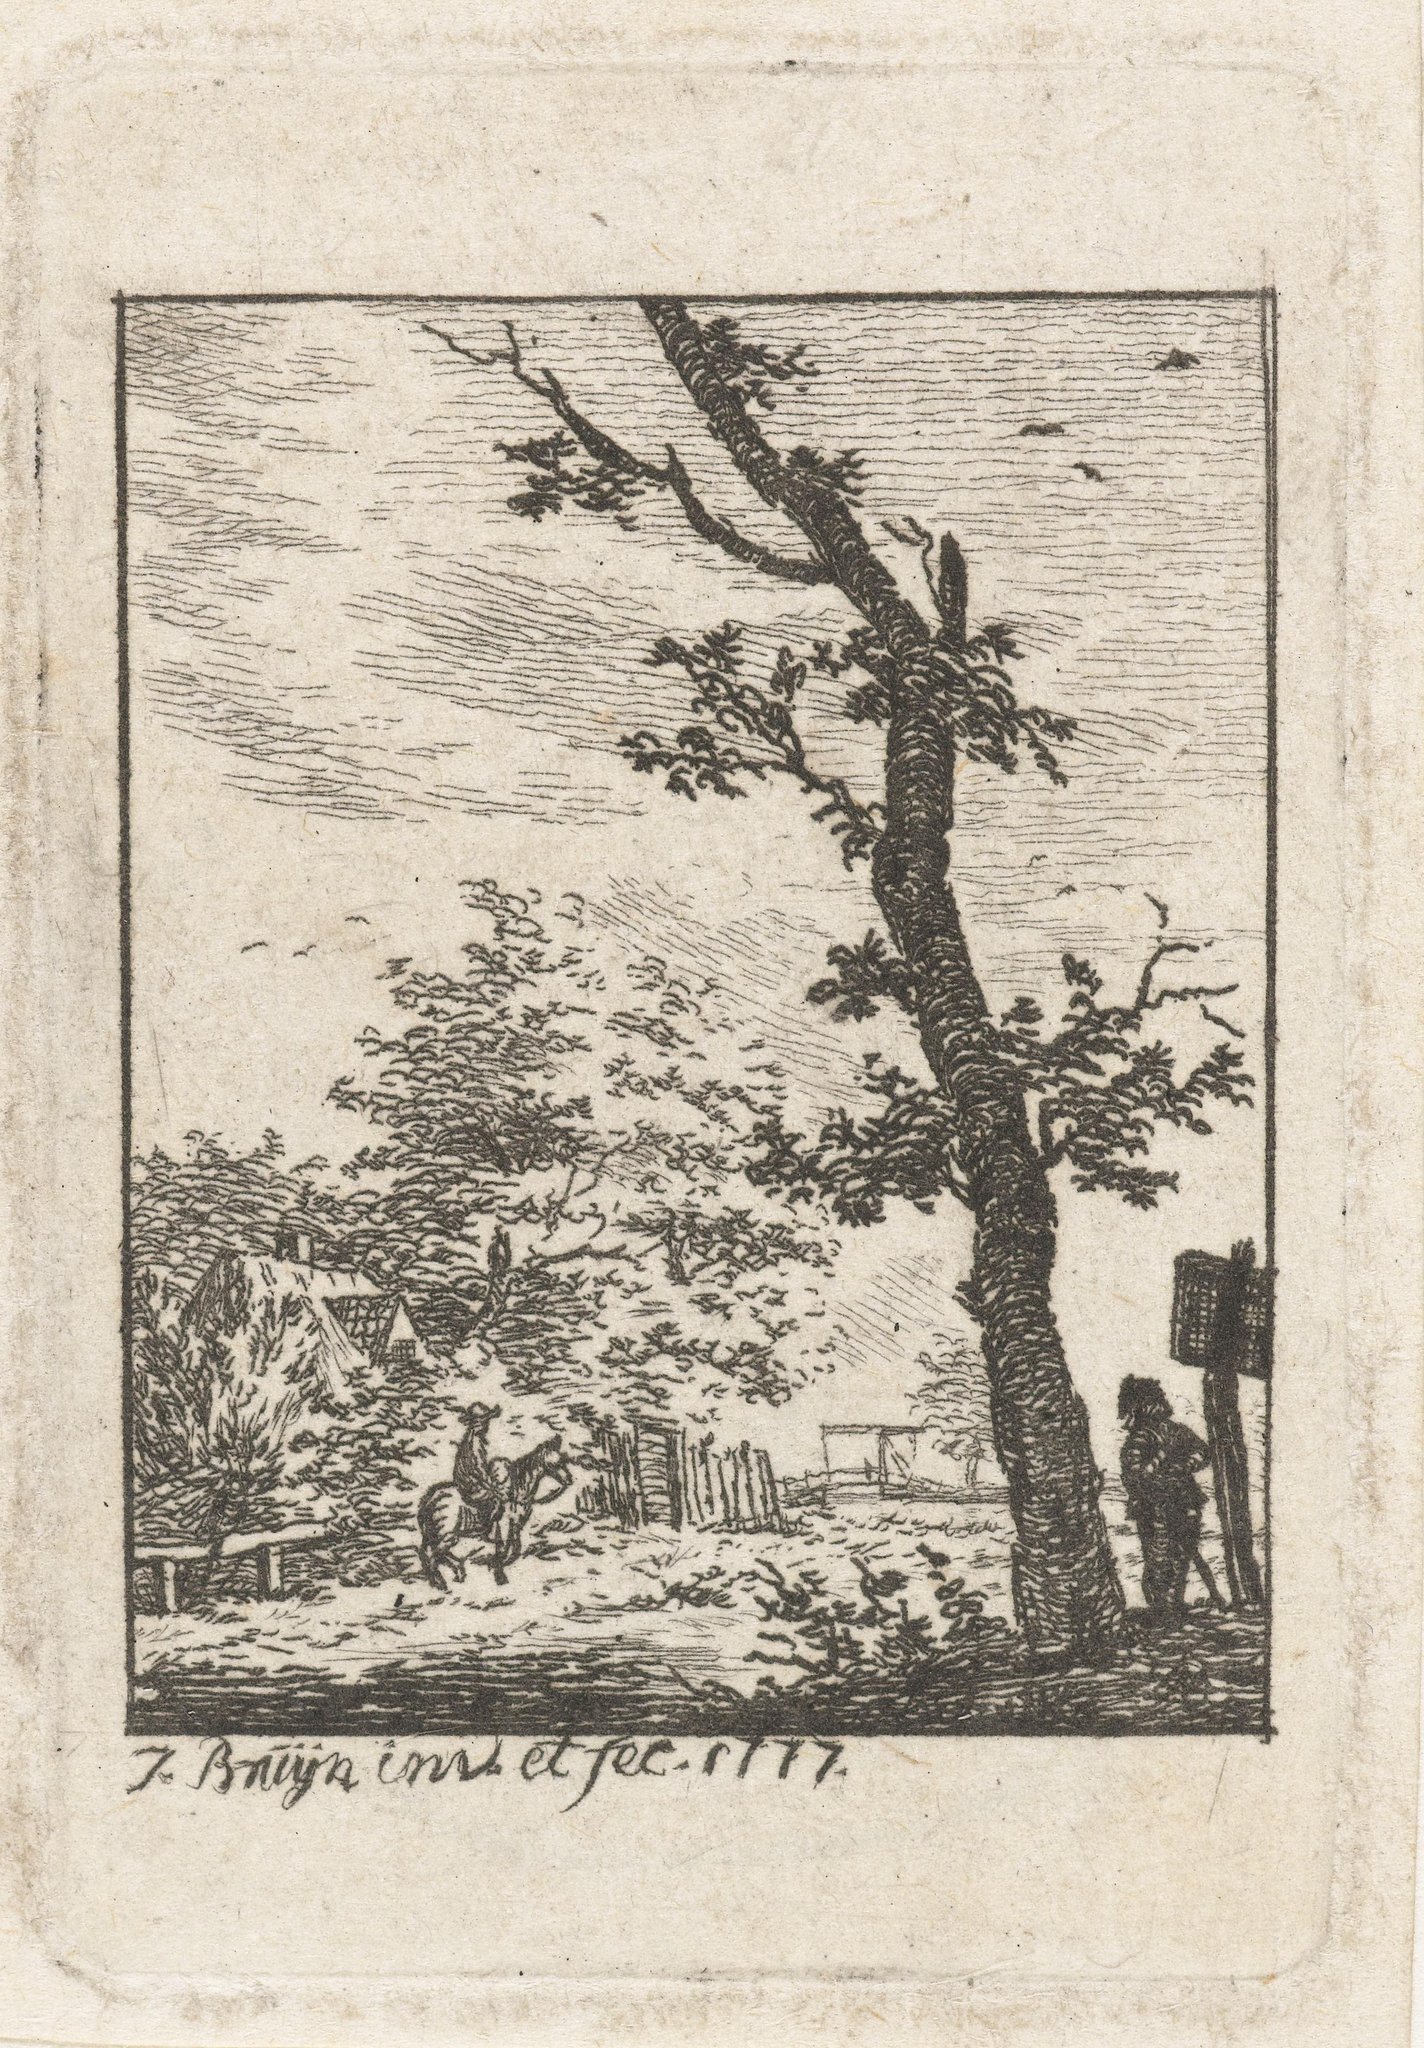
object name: print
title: Landschap met ruiter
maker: johanna de bruyn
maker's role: draughtsman, print maker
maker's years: 1722-1782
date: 1777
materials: paper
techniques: etching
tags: lane, alley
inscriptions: collector's mark: Lugt 2228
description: Landschap met ruiter, een hoeve en een wandelaar.